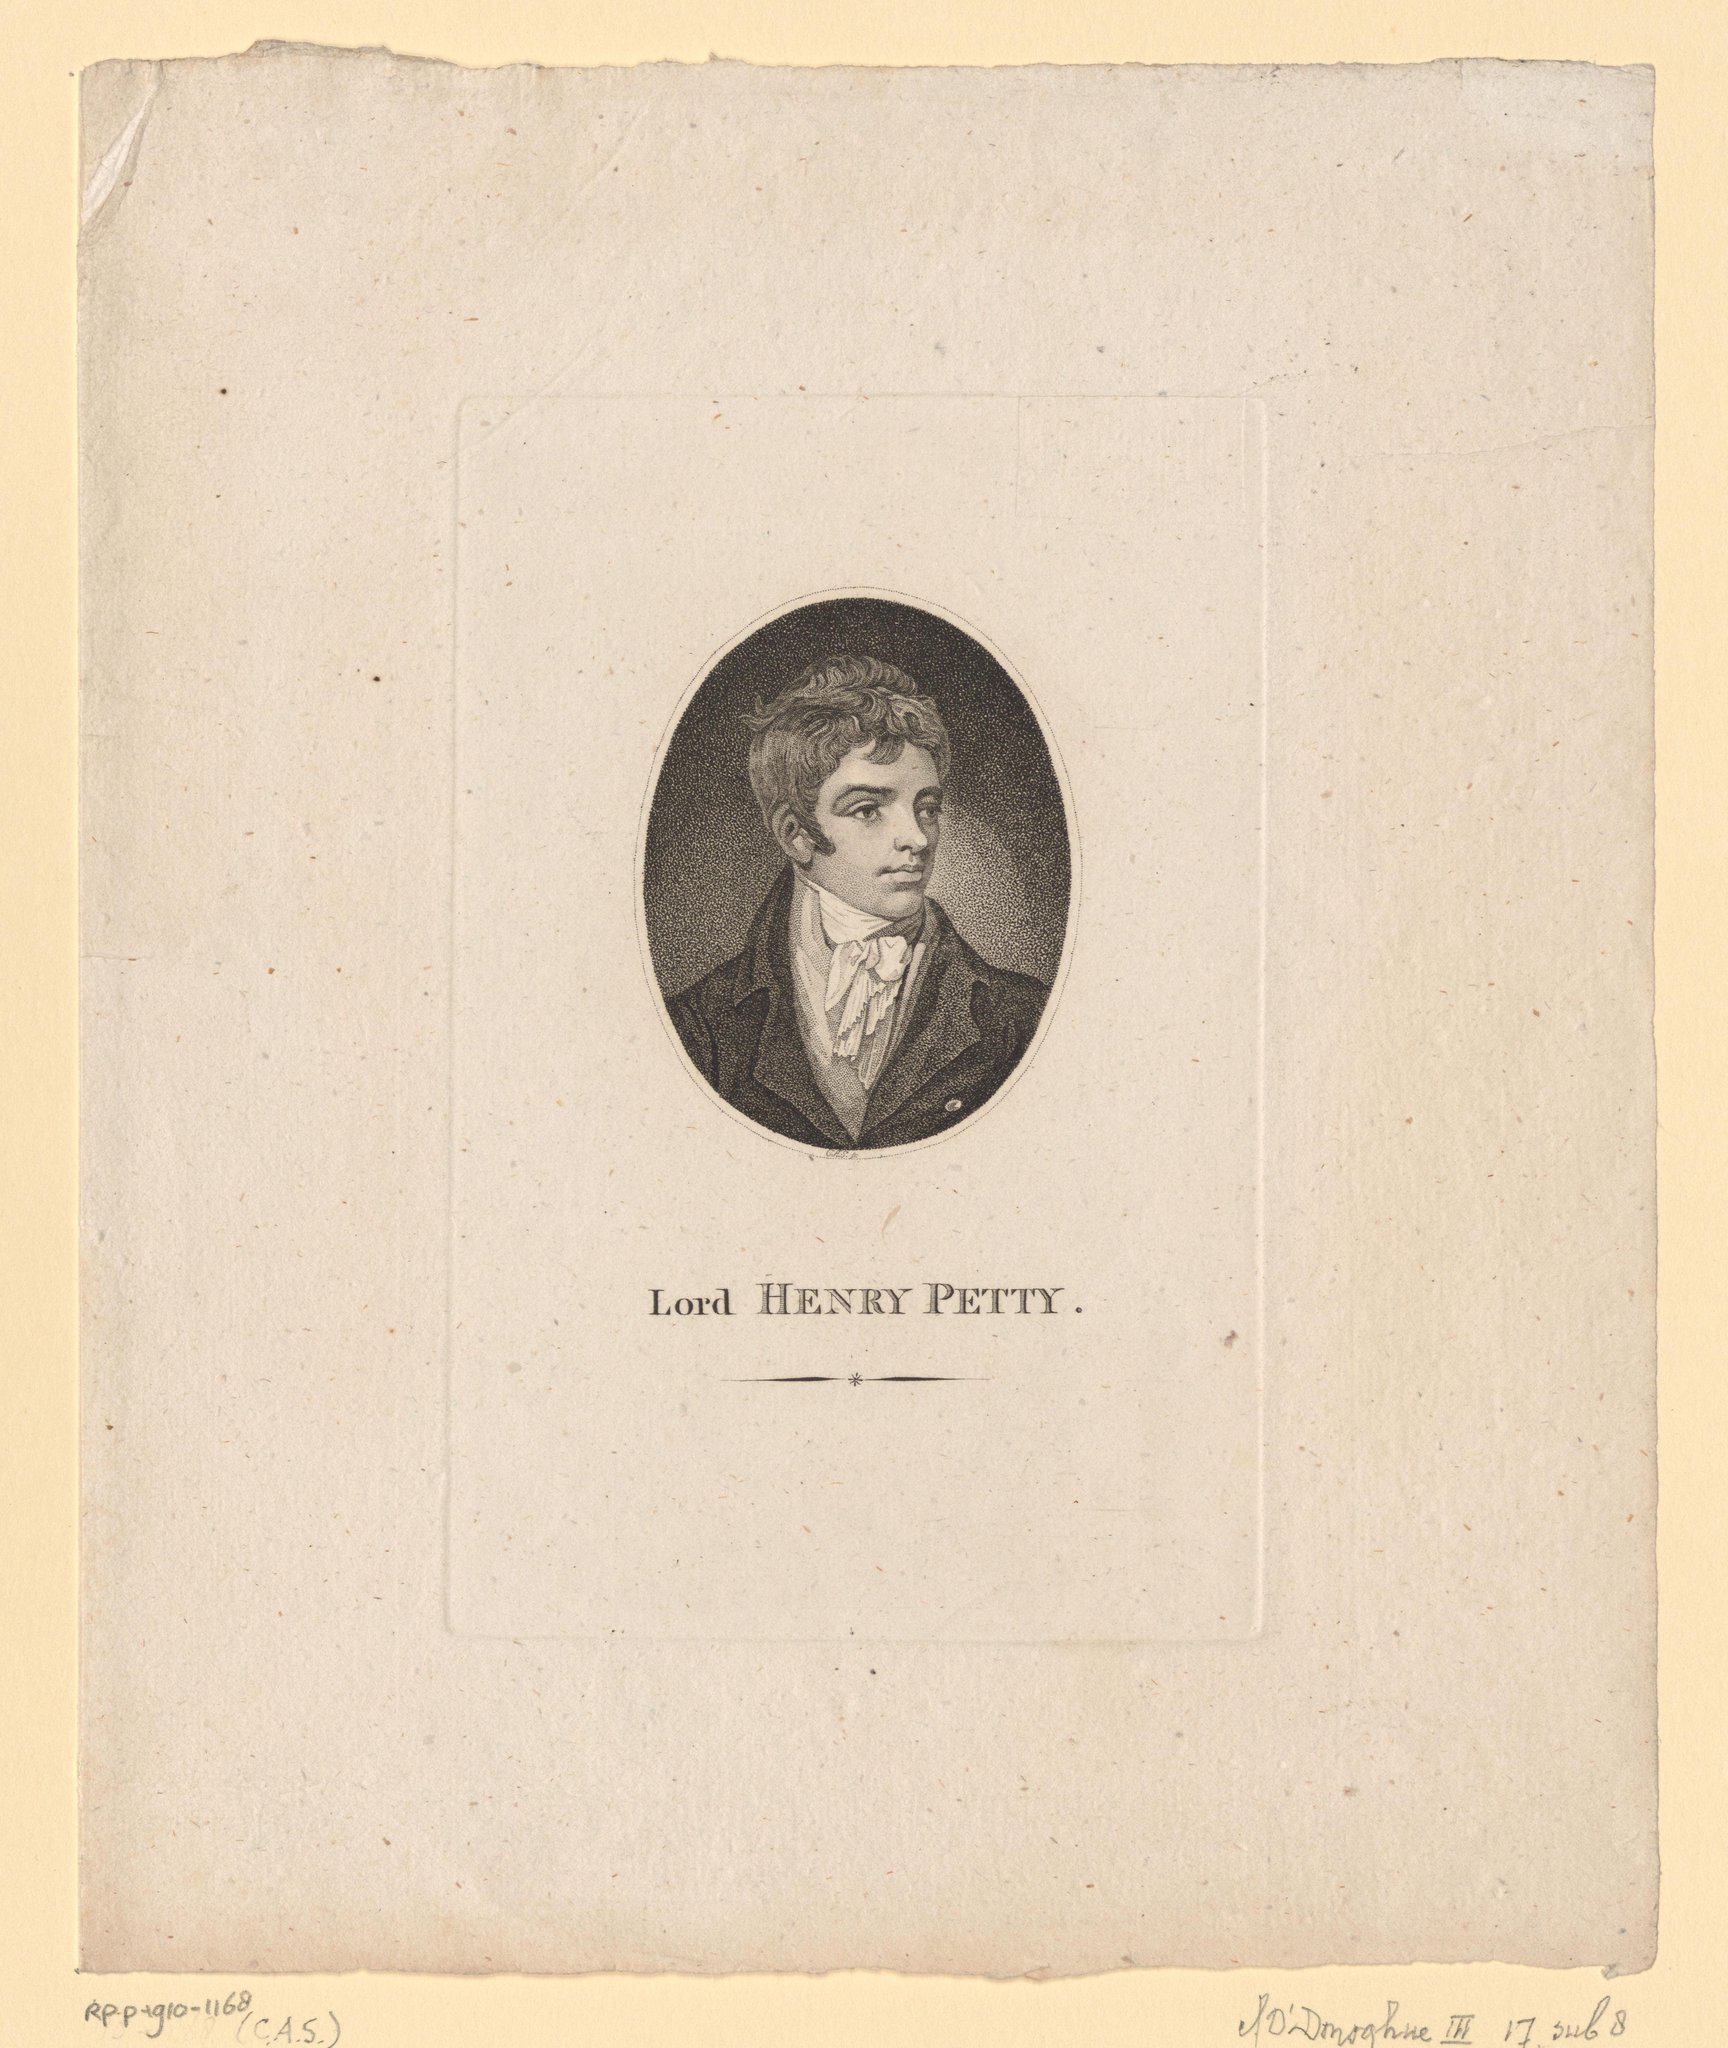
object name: print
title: Portret van Henry Petty-Fitzmaurice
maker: Anonymous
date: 1800-1899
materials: paper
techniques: engraving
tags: politician, historical persons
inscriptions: monogram, collector's mark: Lugt 2228